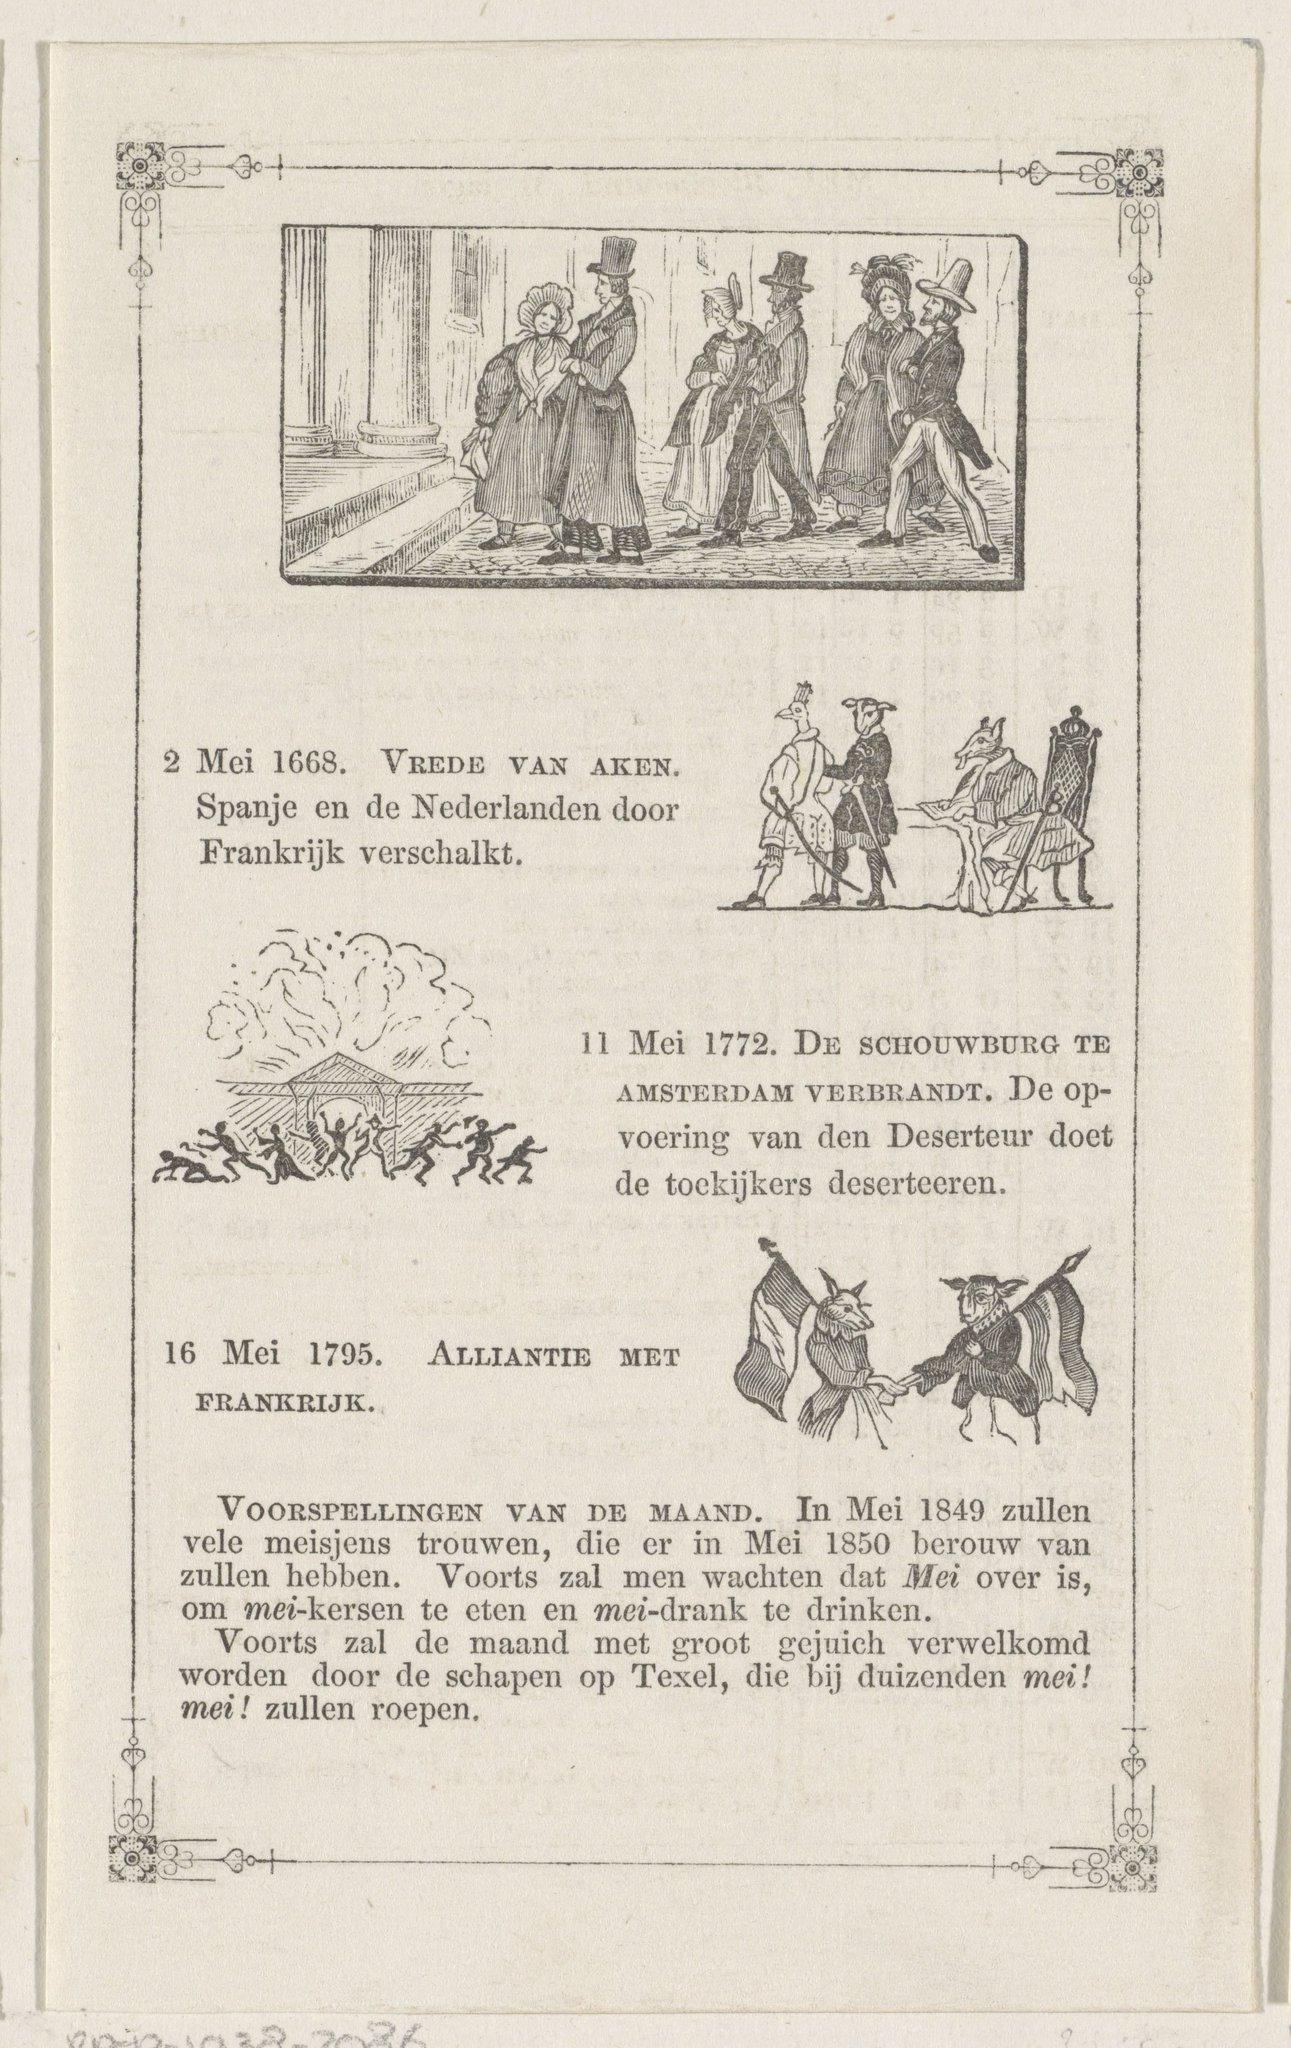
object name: book illustration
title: Mei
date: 1849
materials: paper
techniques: letterpress printing, engraving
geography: amsterdam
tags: alliance with france (1795)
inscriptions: collector's mark: Lugt 2760, collector's mark: Lugt 2228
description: Midden boven een voorstelling van figuren lopend naar de kerk. Daaronder een aantal voorstellingen van gebeurtenissen die plaatsvonden in de maand mei, waaronder de Vrede van Aken in 1668 en de alliantie met Frankrijk in 1795. Midden onder voorspellingen voor de maand mei in 1849.